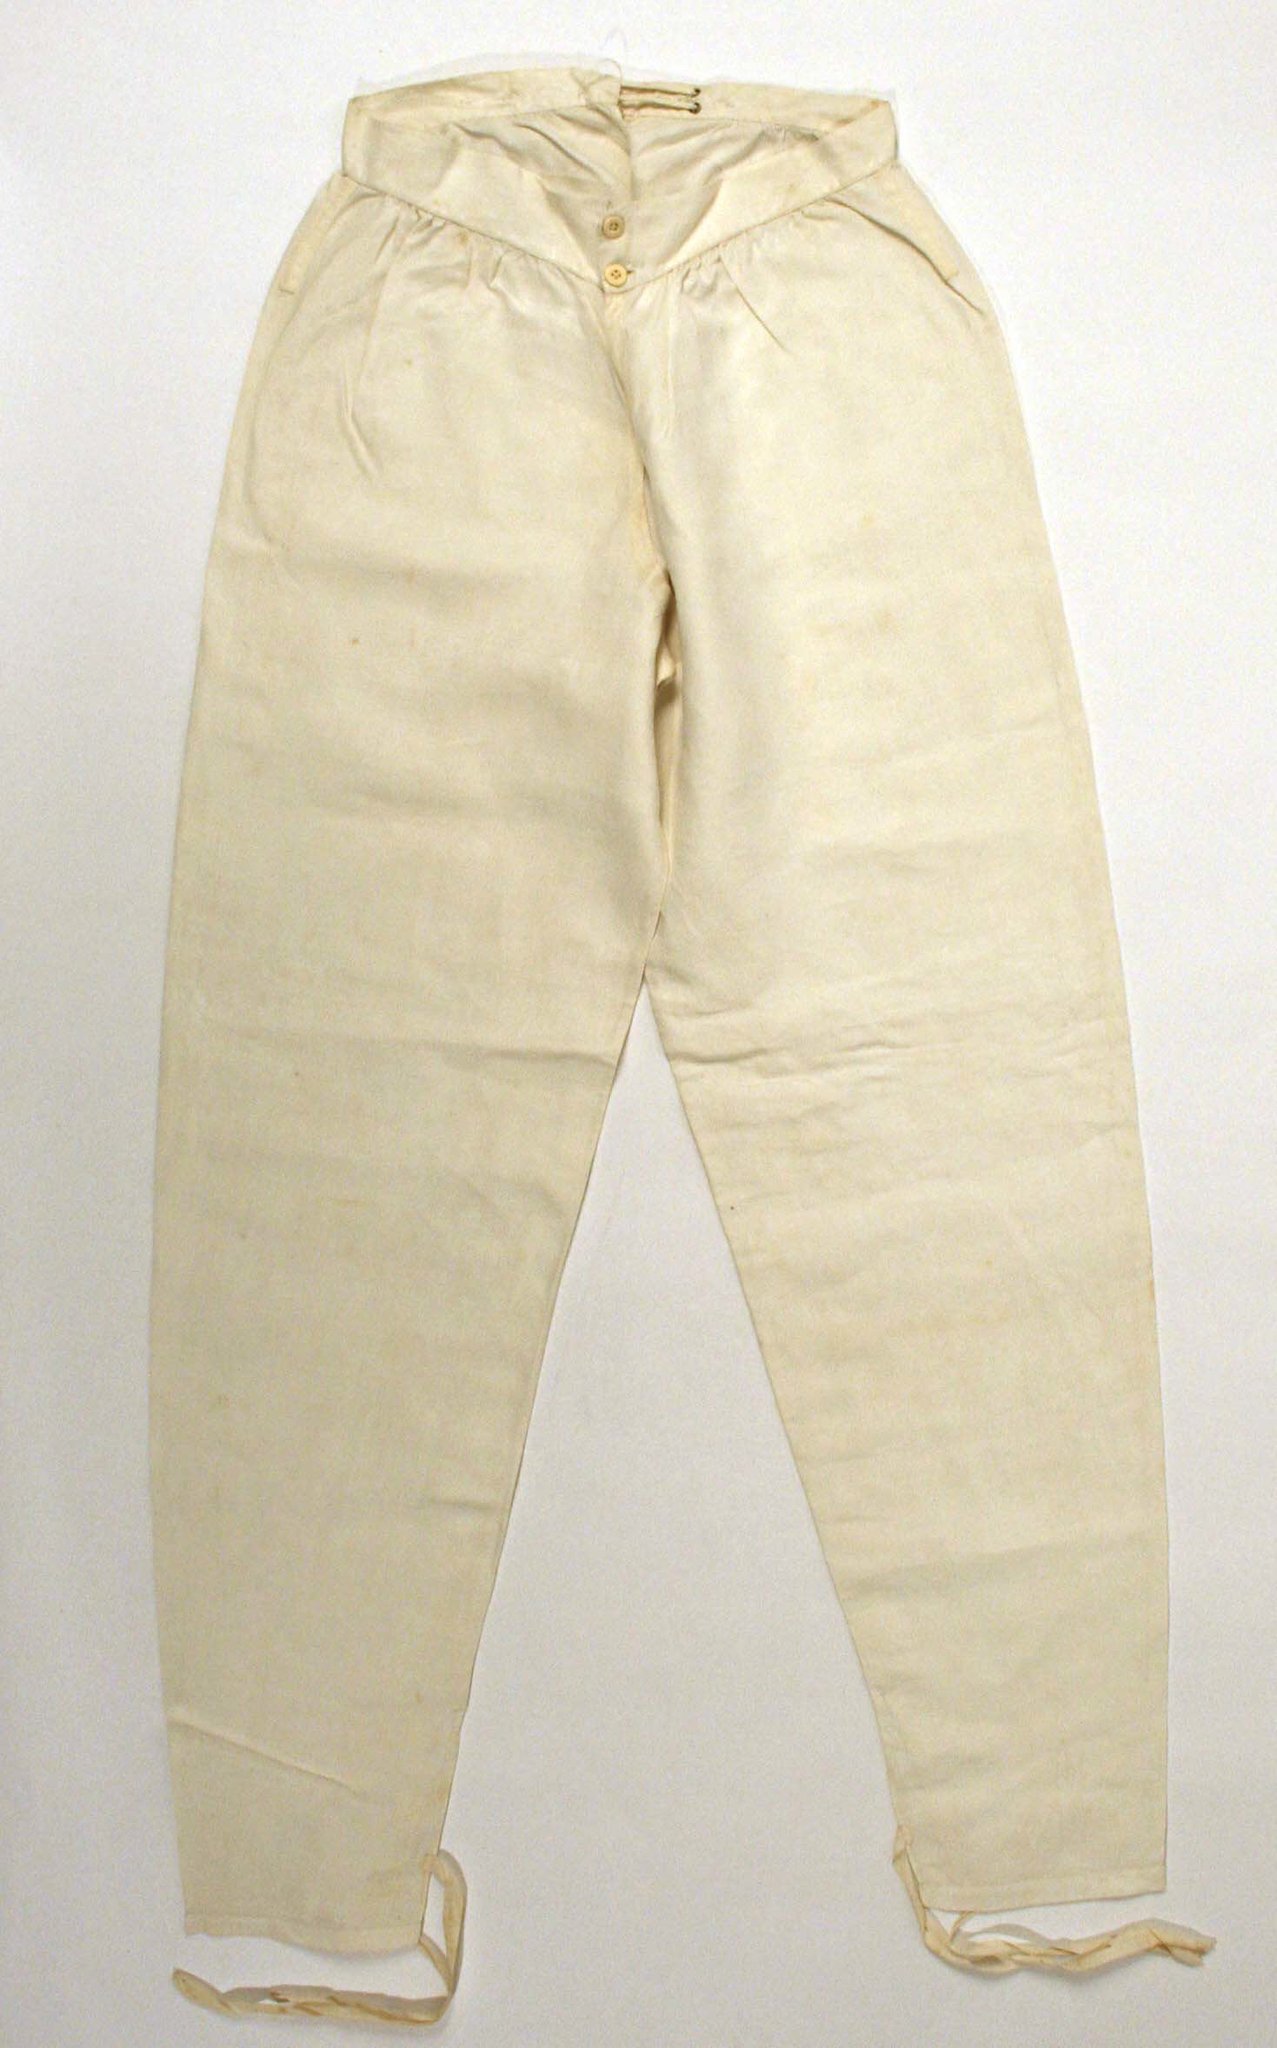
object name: drawer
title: Drawers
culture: american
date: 1801-1833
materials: linen